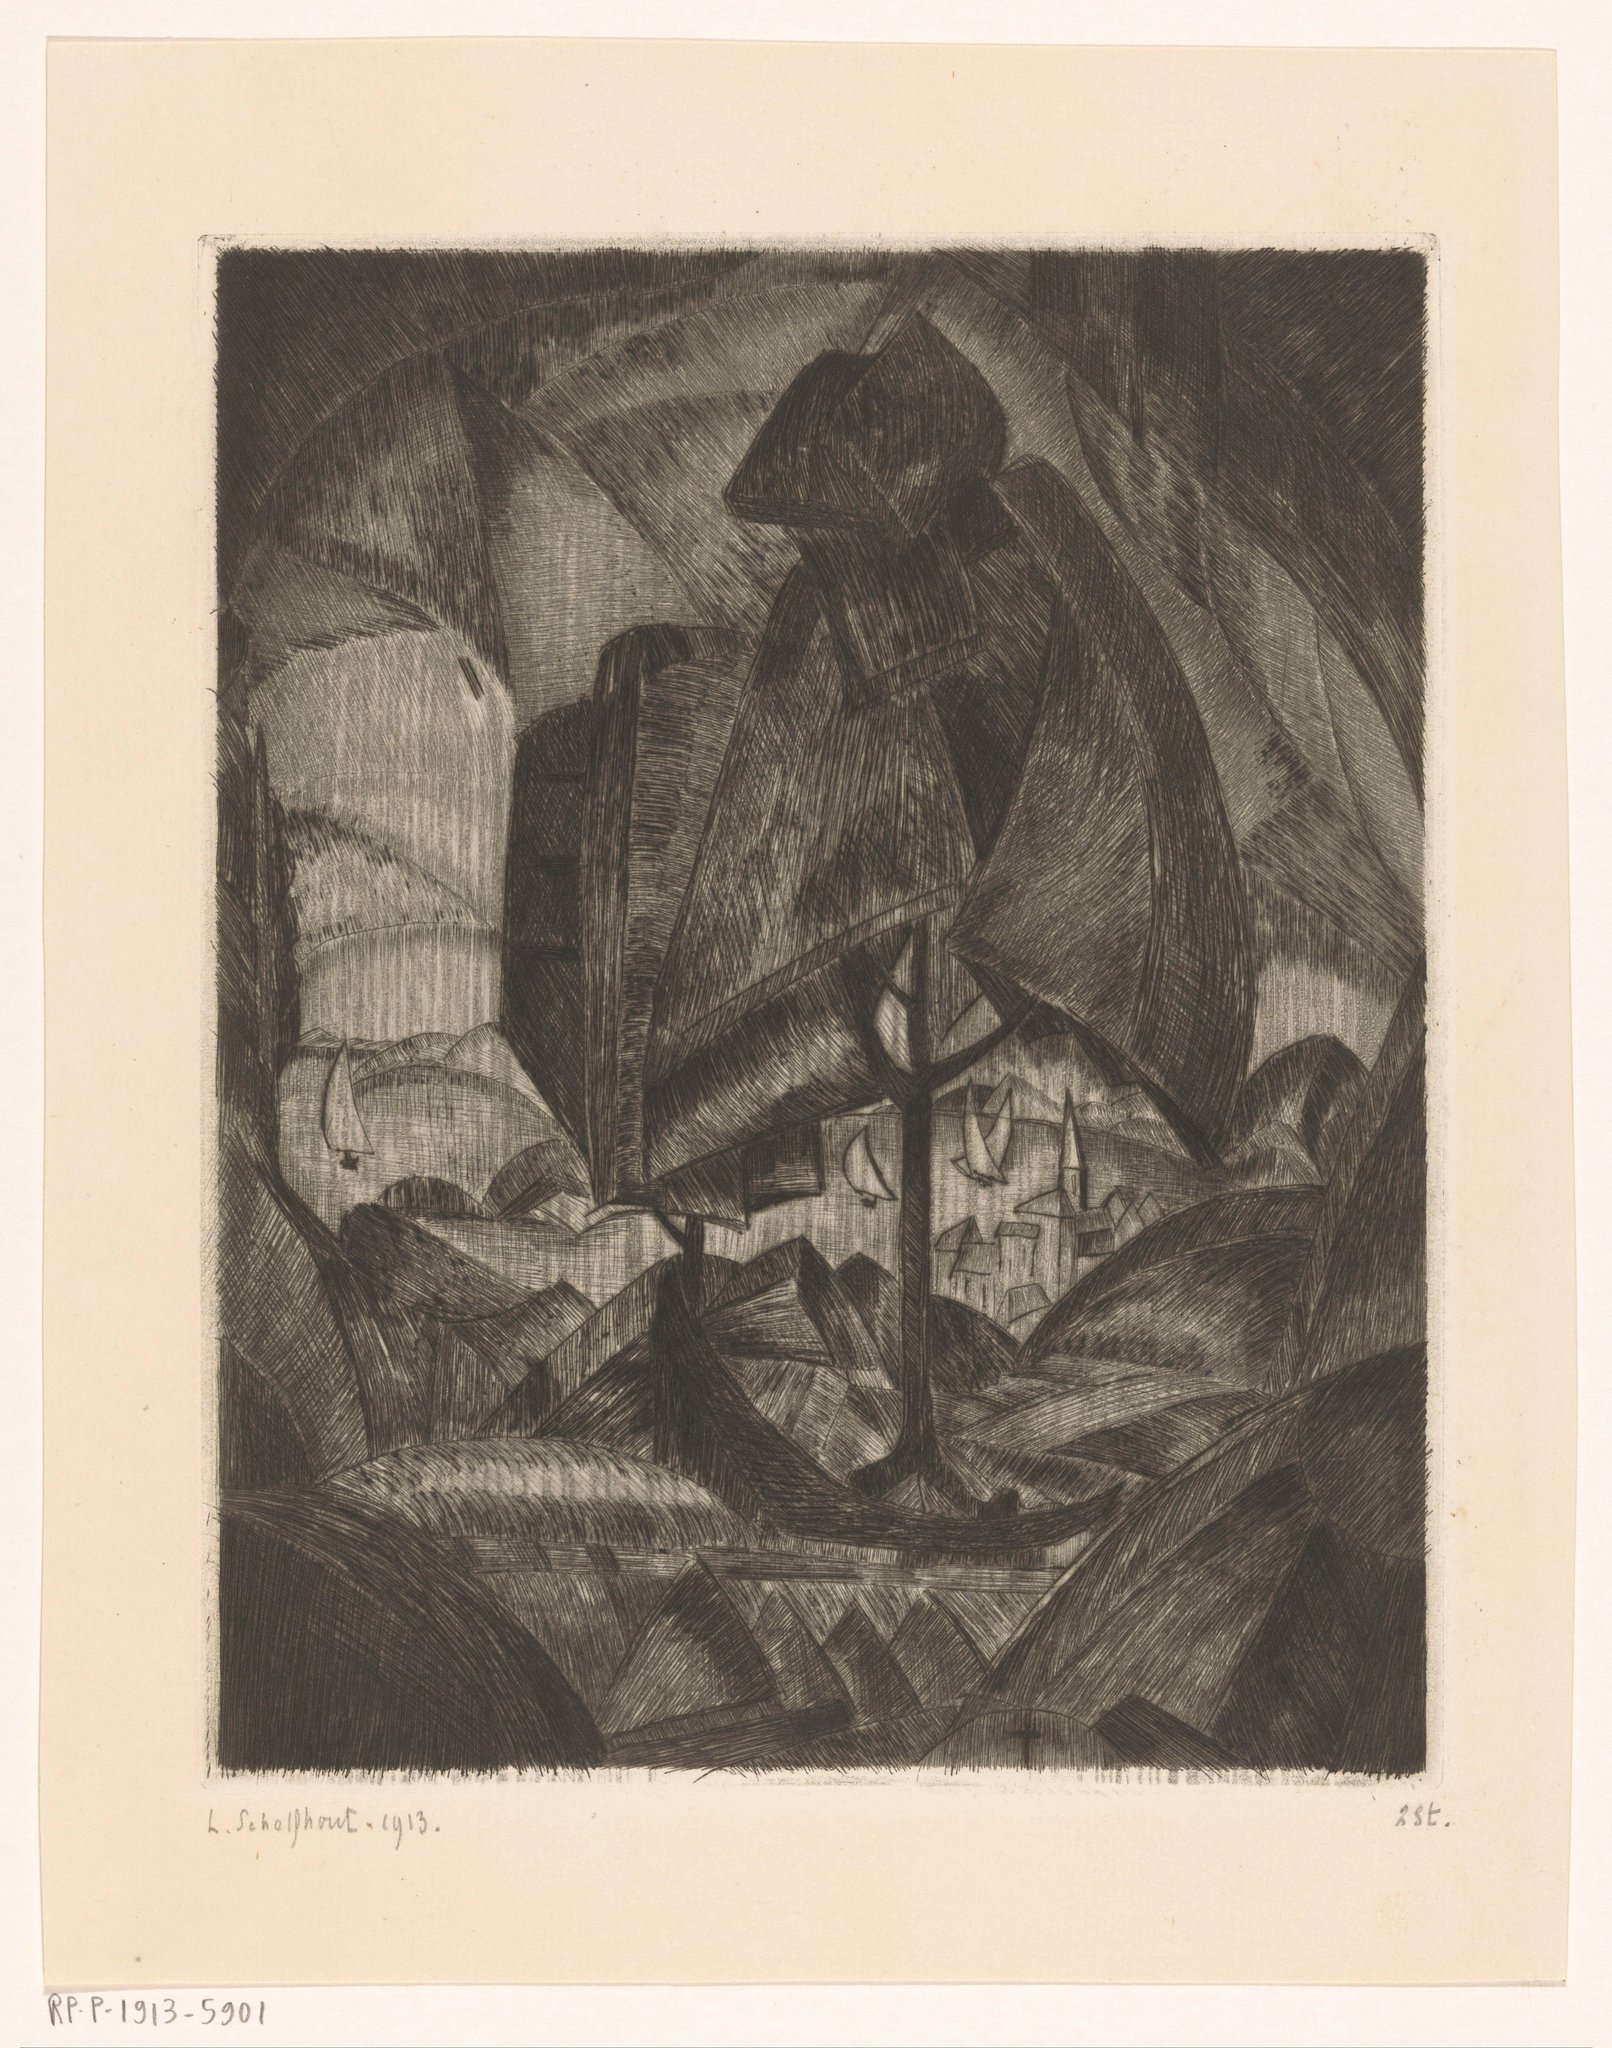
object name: print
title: L'Arbre près d'un lac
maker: lodewijk schelfhout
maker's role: draughtsman, print maker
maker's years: 1881-1943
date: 1913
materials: paper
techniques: drypoint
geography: paris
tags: trees, sailing-ship, sailing-boat, lake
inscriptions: collector's mark: Lugt 2233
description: Een boom in een heuvellandschap. Op de achtergrond een nederzetting aan een meer met zeilschepen.